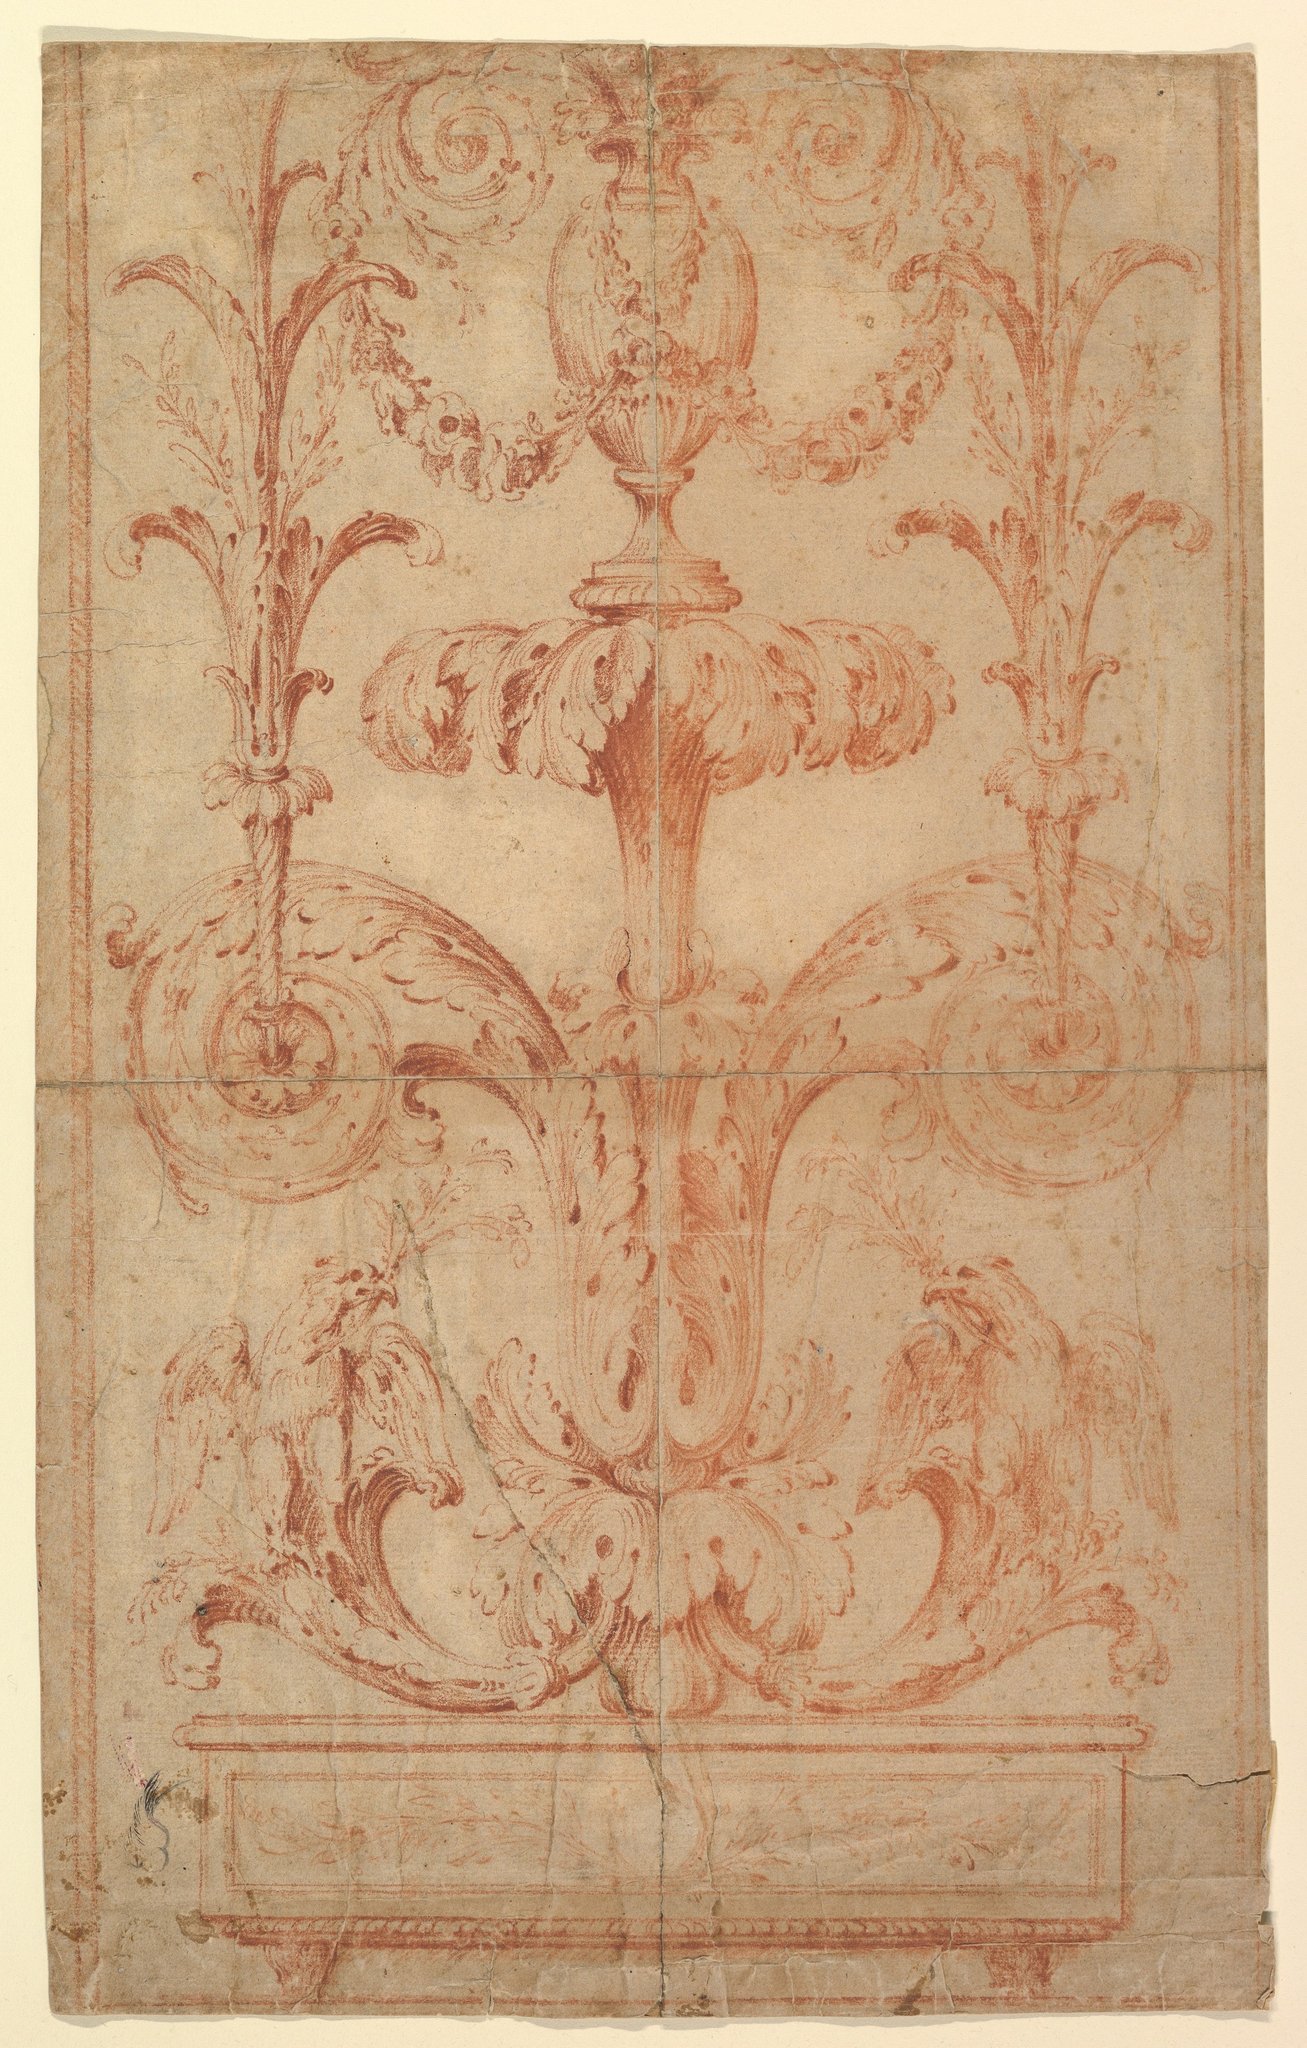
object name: drawing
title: Design for a Decorative Panel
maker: anonymous, french, 18th century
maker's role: artist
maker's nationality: french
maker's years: 1700-1800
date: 1701-1800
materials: chalk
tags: ornament